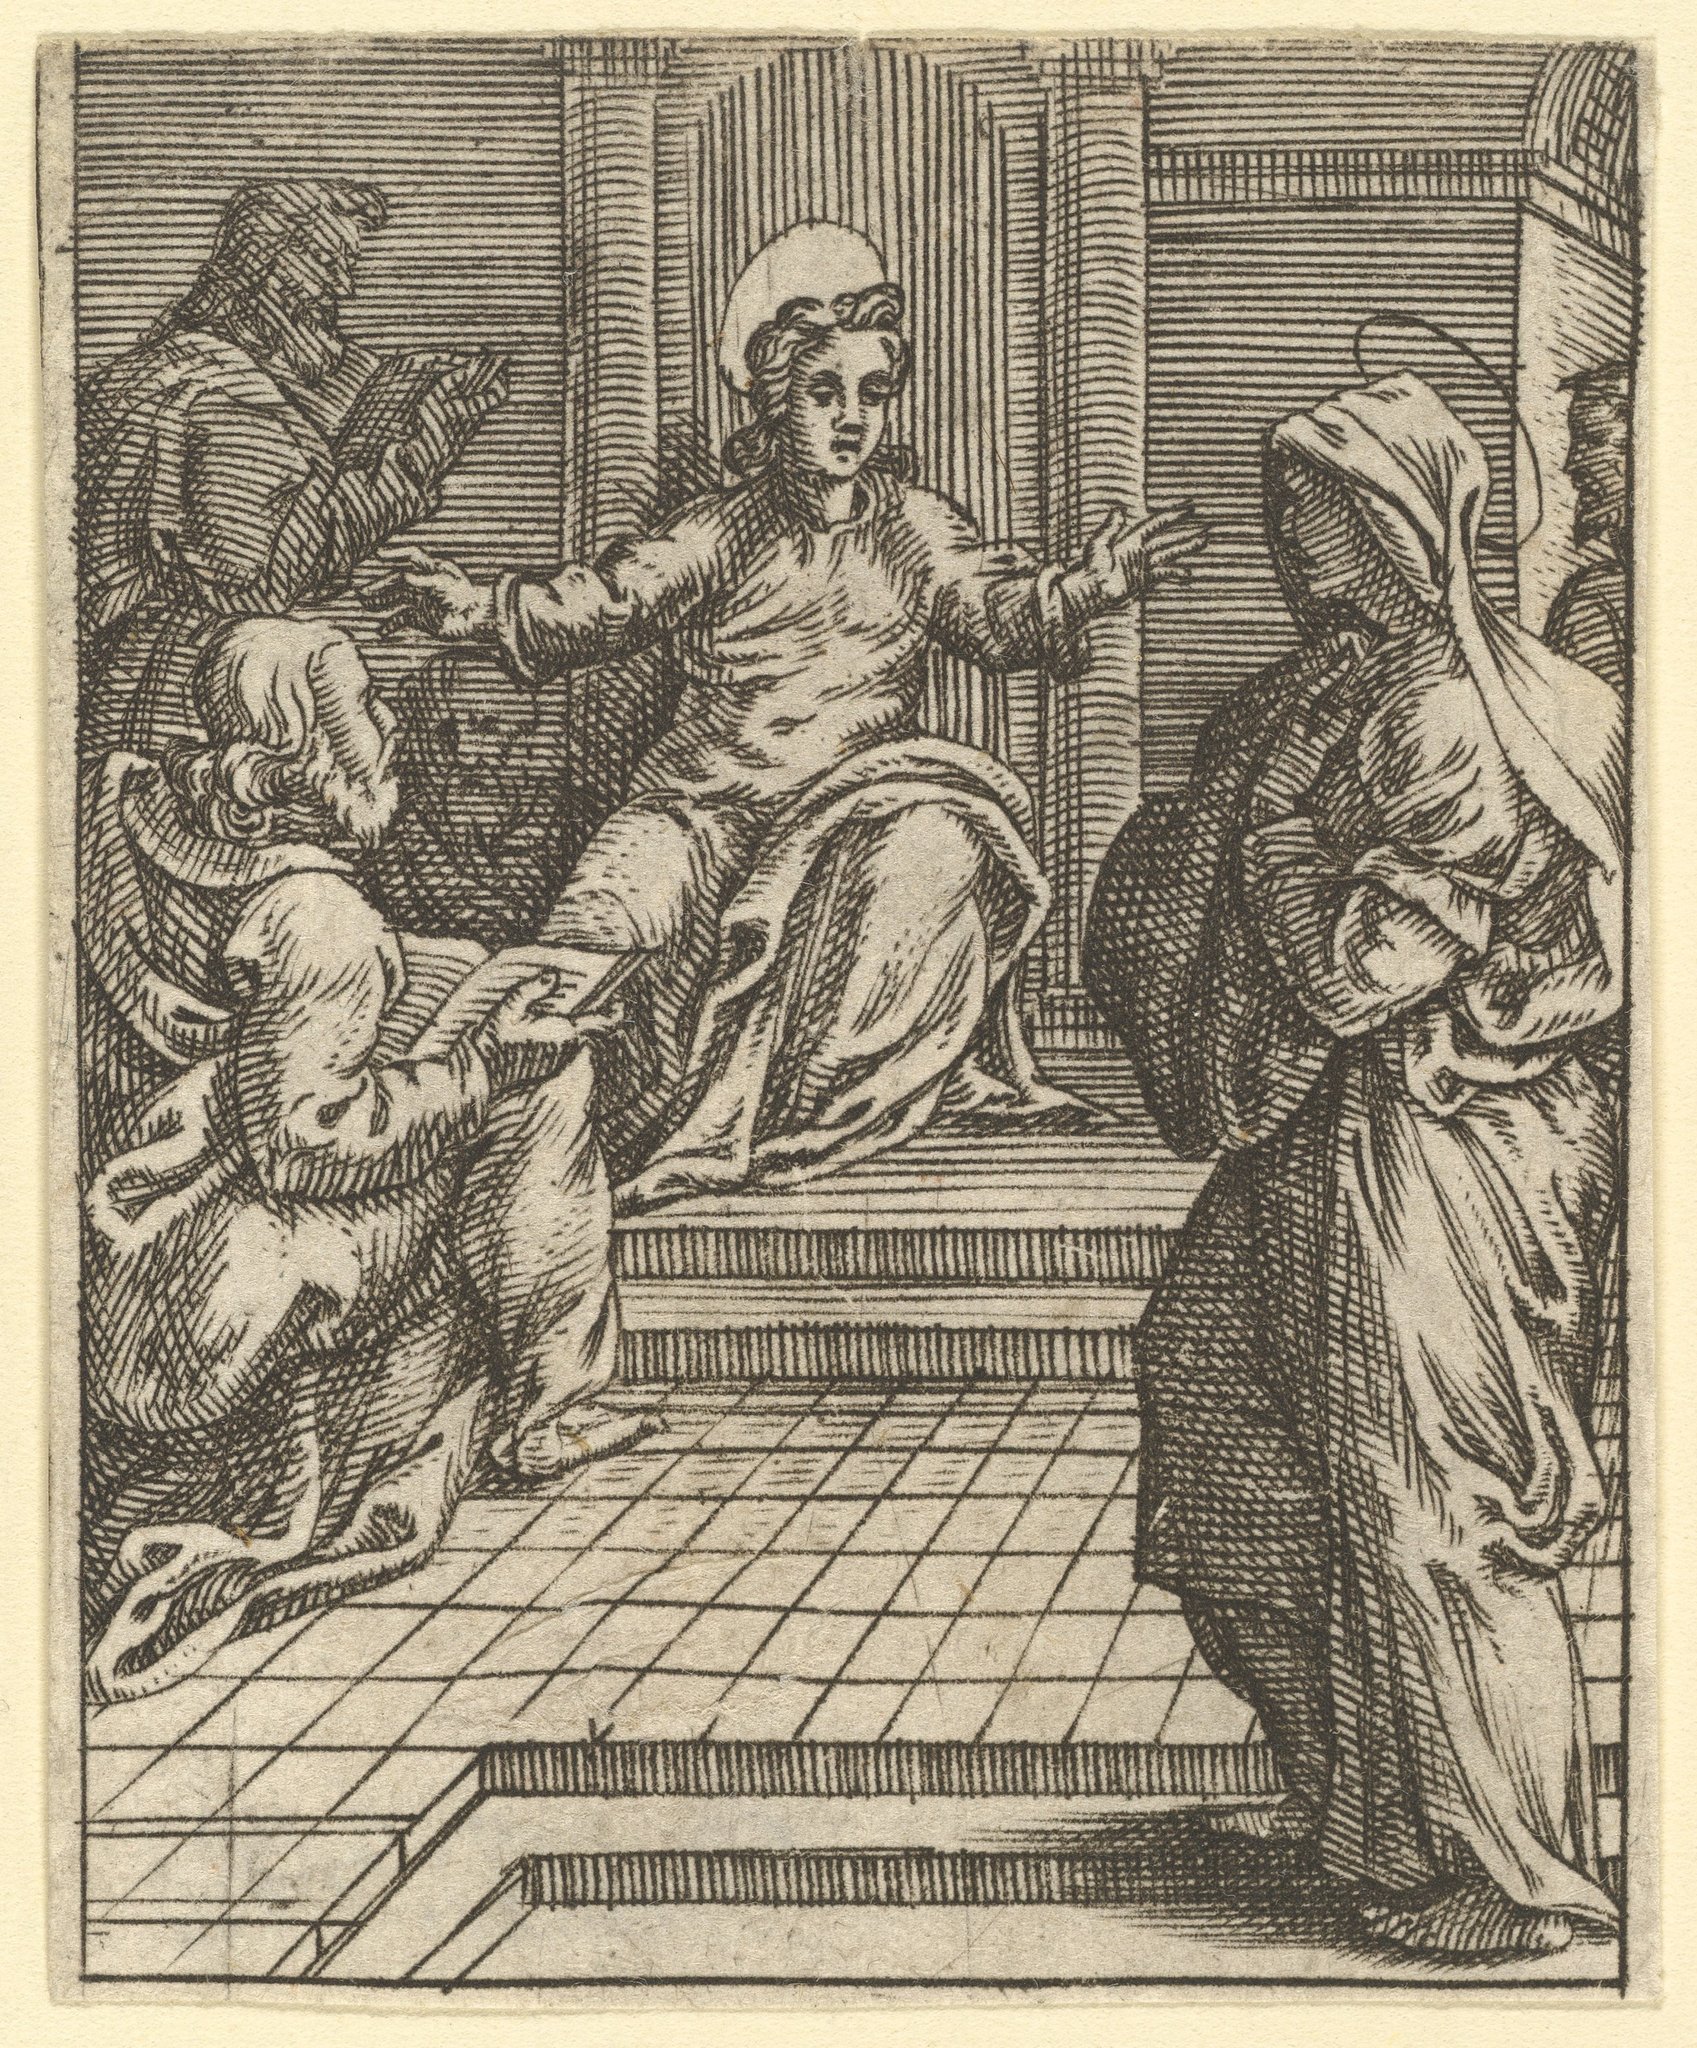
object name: print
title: The Virgin of Sorrows: Christ Disputing with the Doctors; one of nine surrounding compartments from the Virgin of Sorrows, now separated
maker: giorgio ghisi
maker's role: artist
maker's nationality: italian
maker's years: 1515-1582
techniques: engraving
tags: men,reading,christ,virgin mary